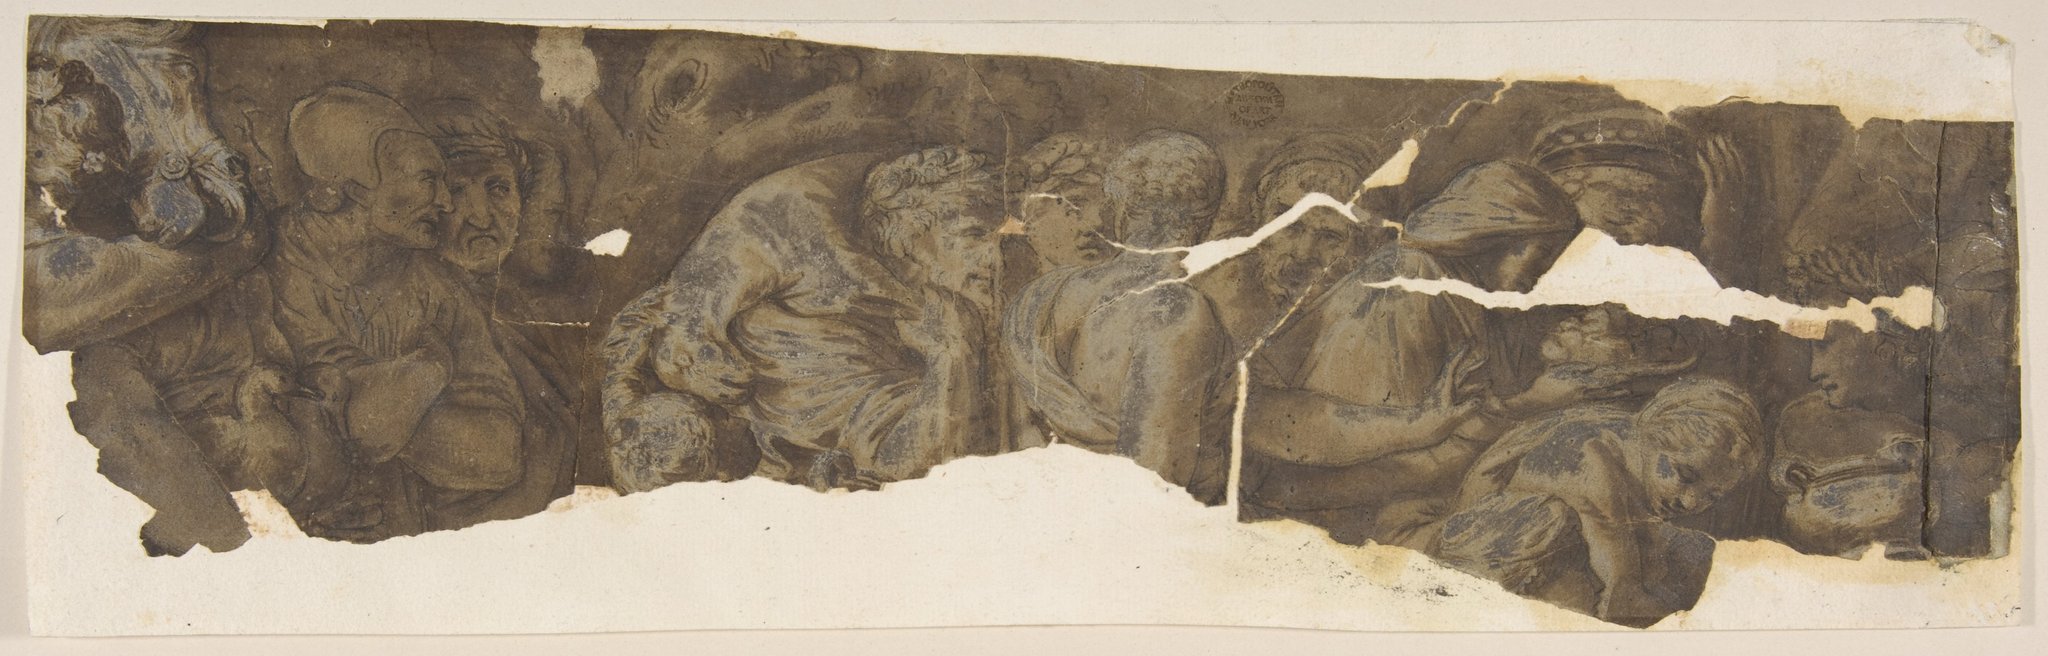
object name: drawing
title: Roman Procession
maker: polidoro da caravaggio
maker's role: artist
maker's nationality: italian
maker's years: 1494-1548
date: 1499-1543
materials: ink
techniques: brush, highlighting, pen, wash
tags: men